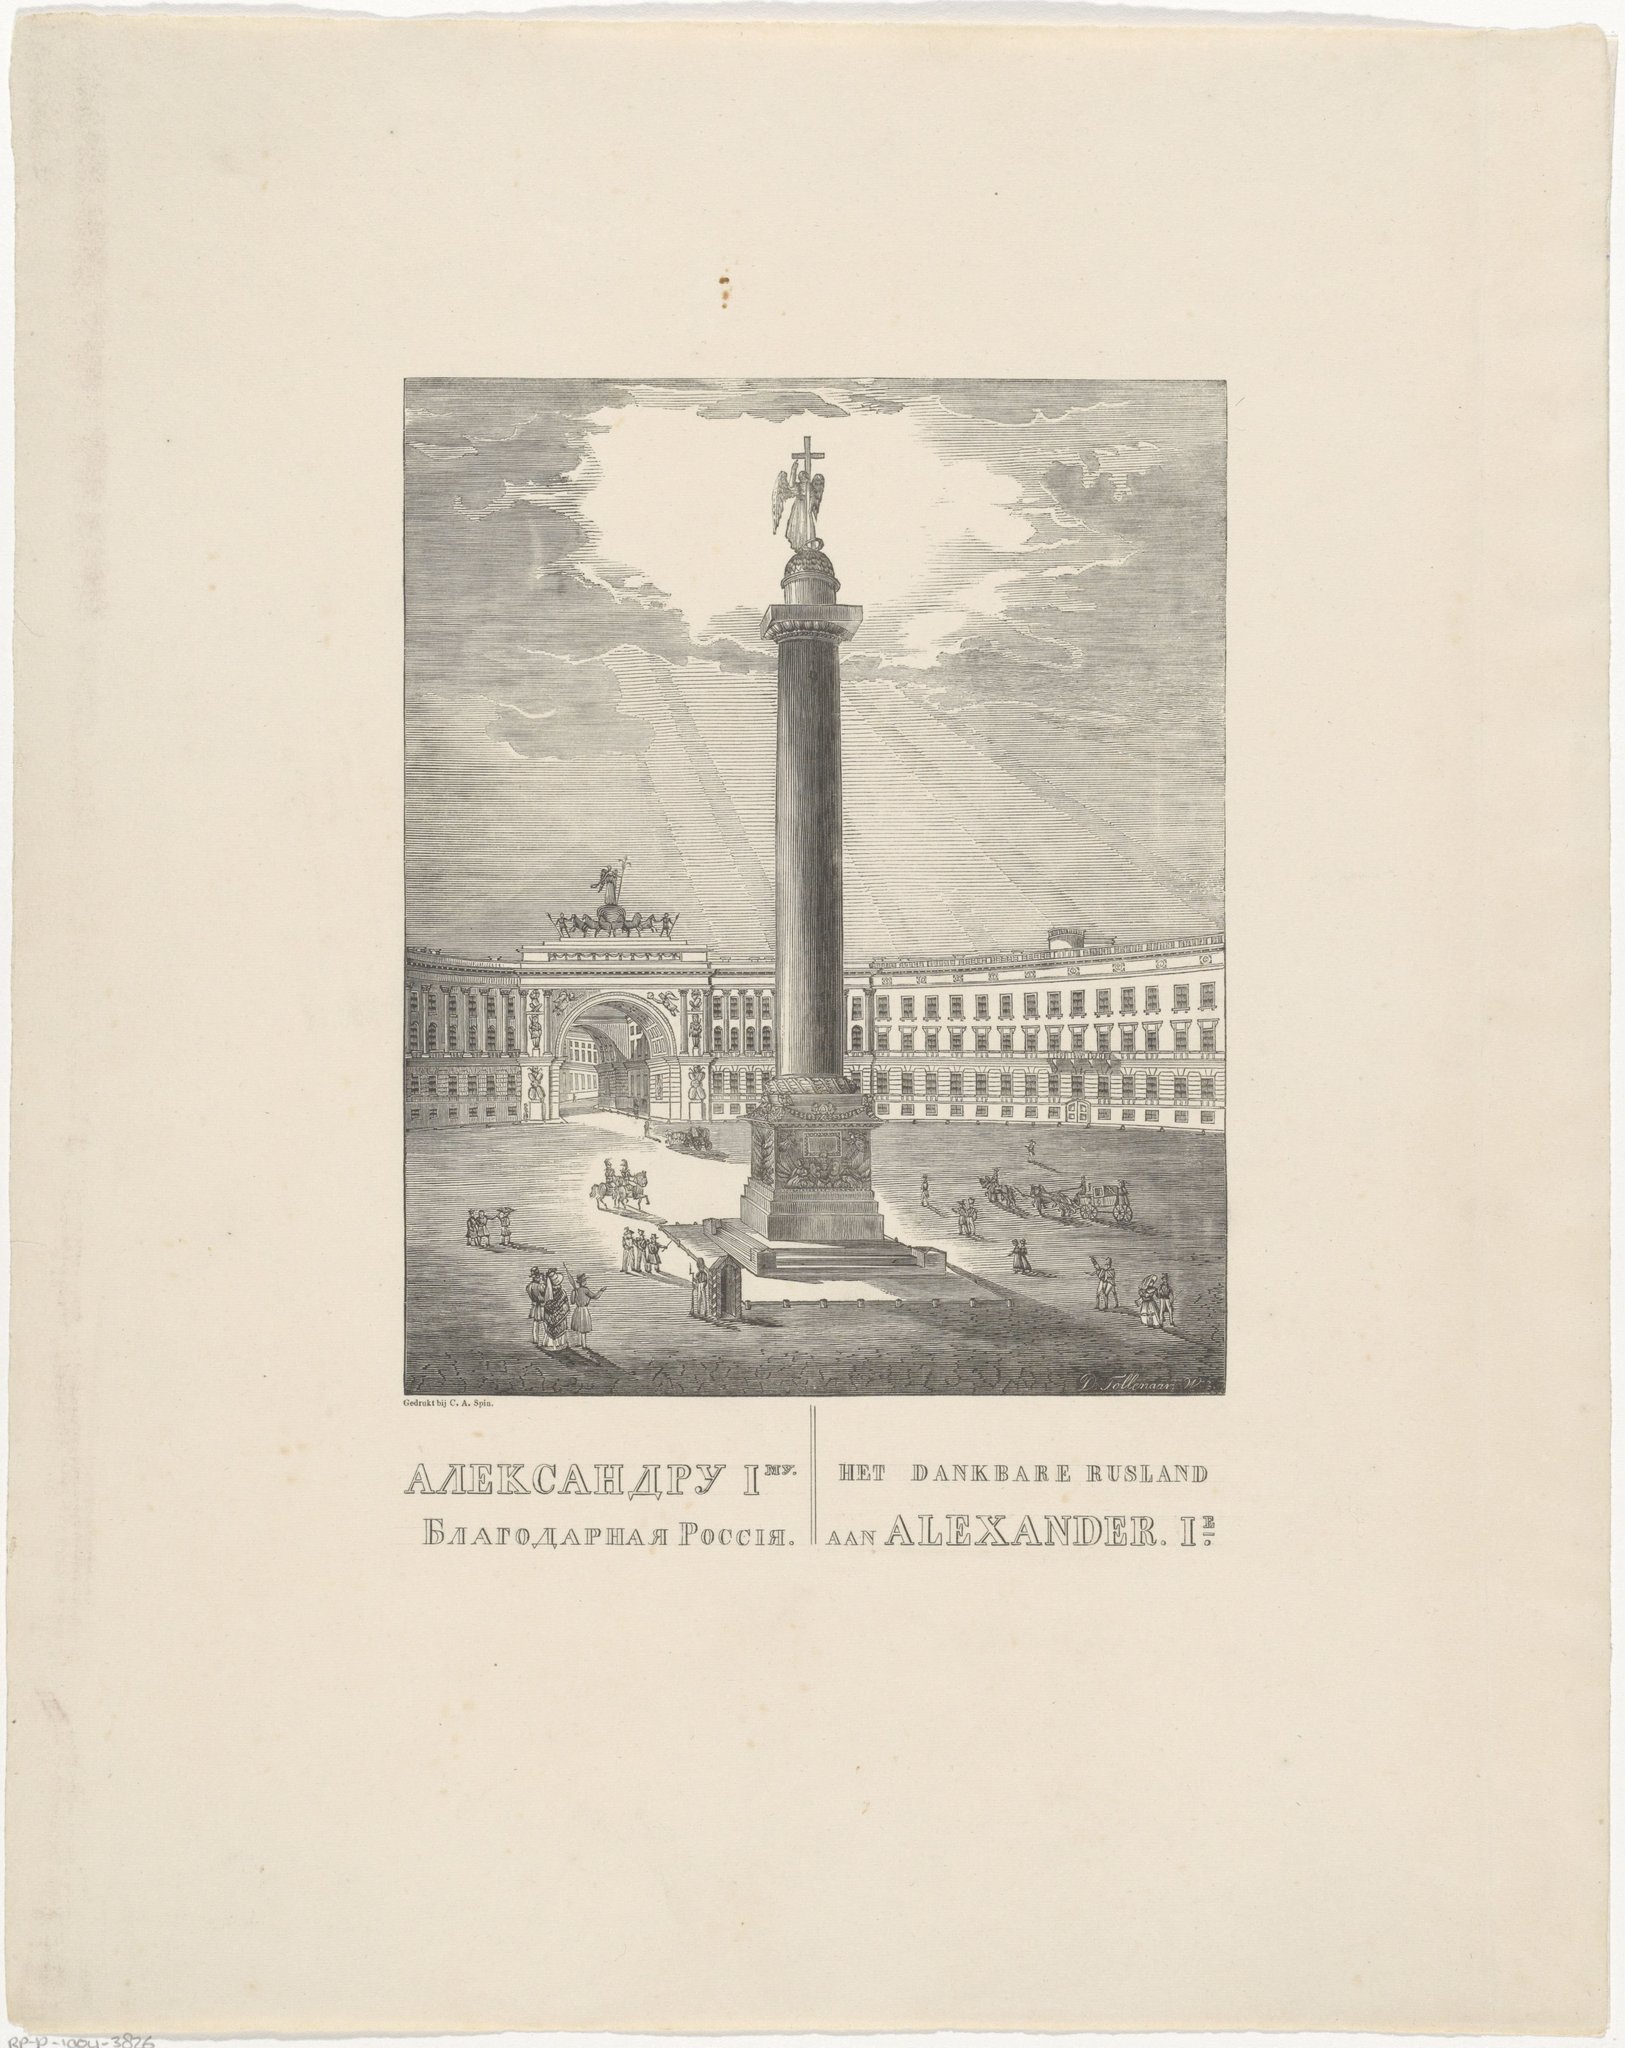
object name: print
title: Monument voor Alexander I, tsaar van Rusland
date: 1818-1858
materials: paper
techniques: engraving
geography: netherlands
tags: alexander i (tsaar van rusland), monument, statue, square, place, circus, etc. (+ city(-scape) with figures, staffage)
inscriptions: collector's mark: Lugt 2228